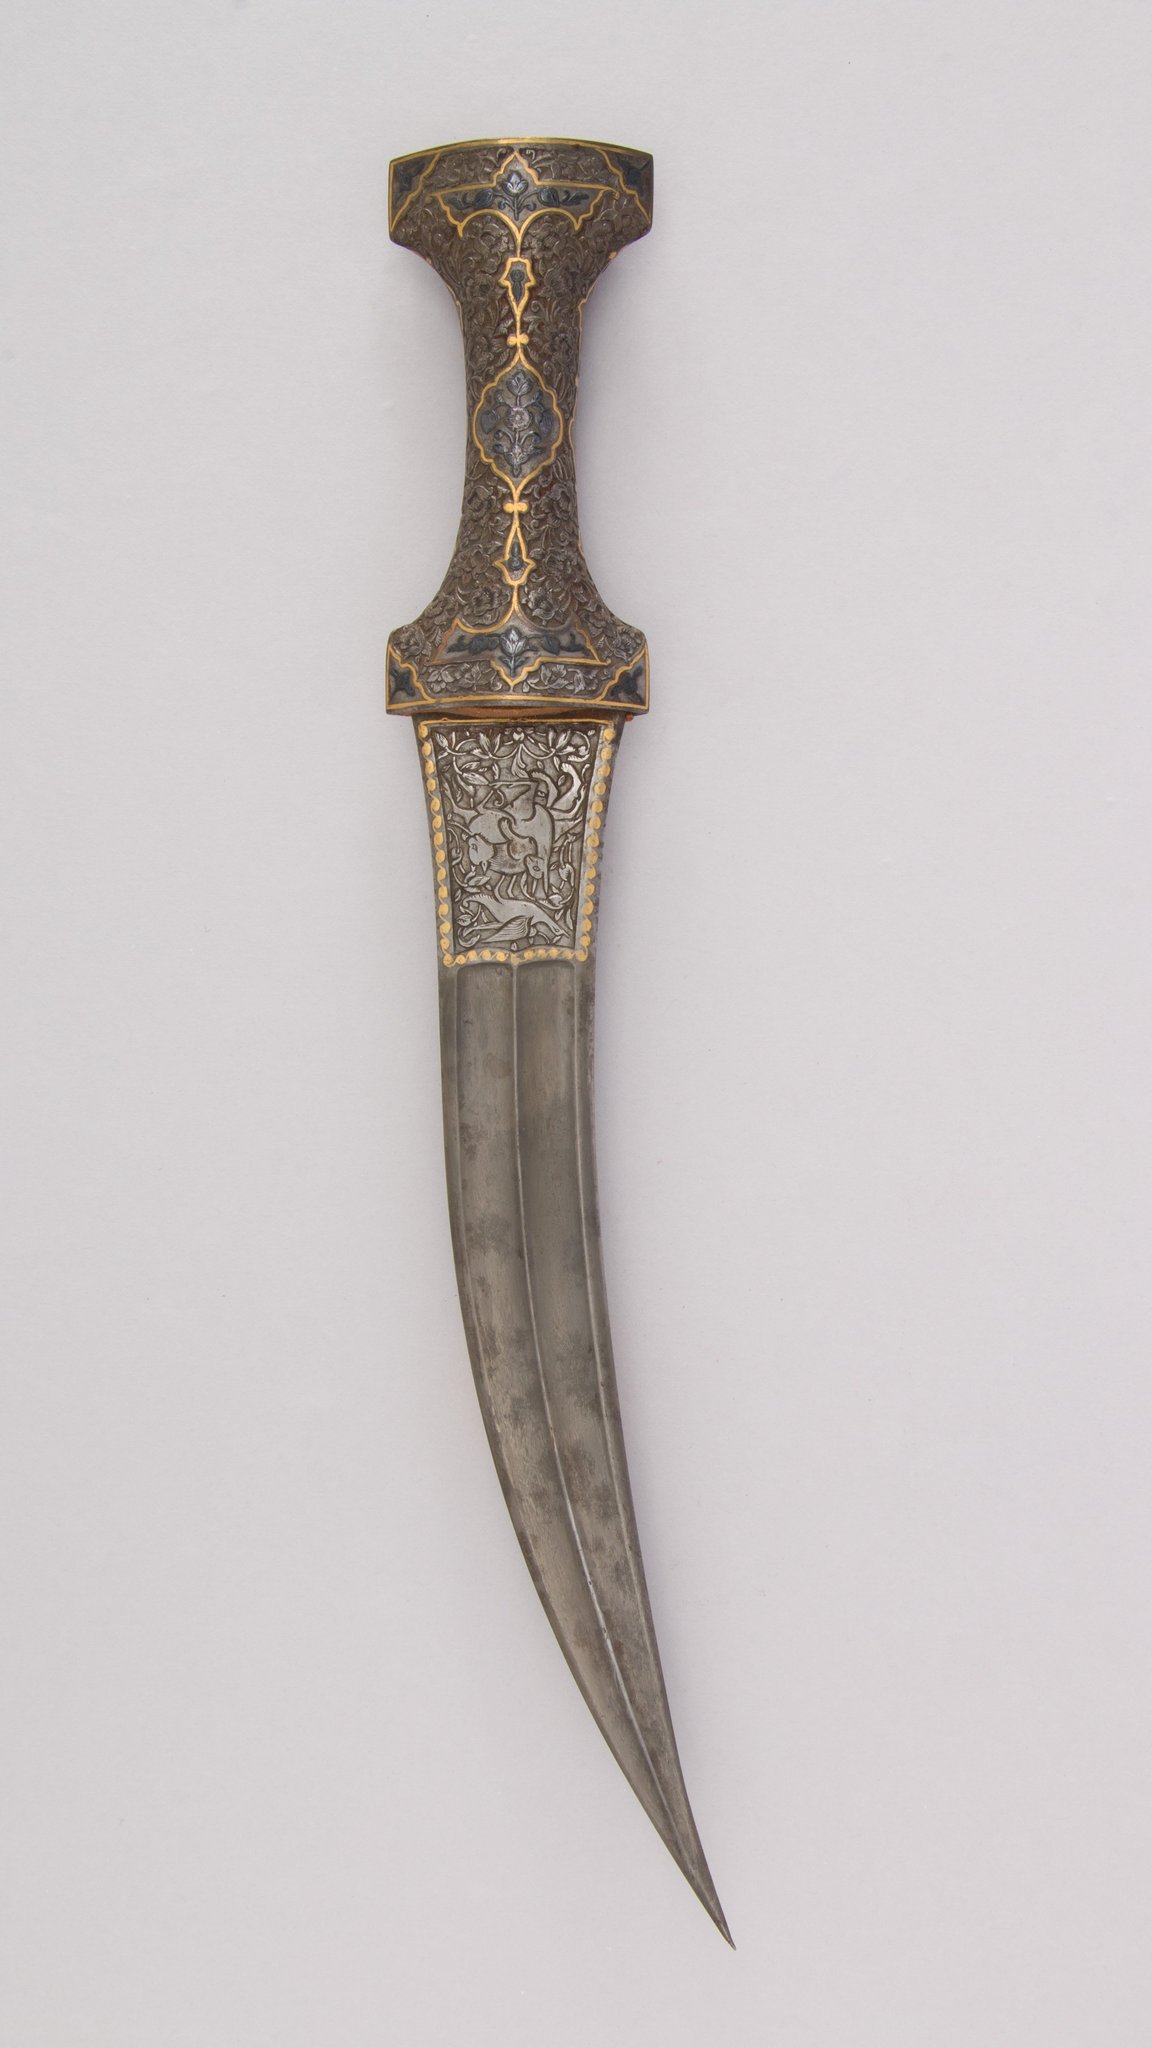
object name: dagger jambiya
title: Dagger (Jambiya)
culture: persian, qajar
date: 1801-1900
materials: gold, steel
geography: iran